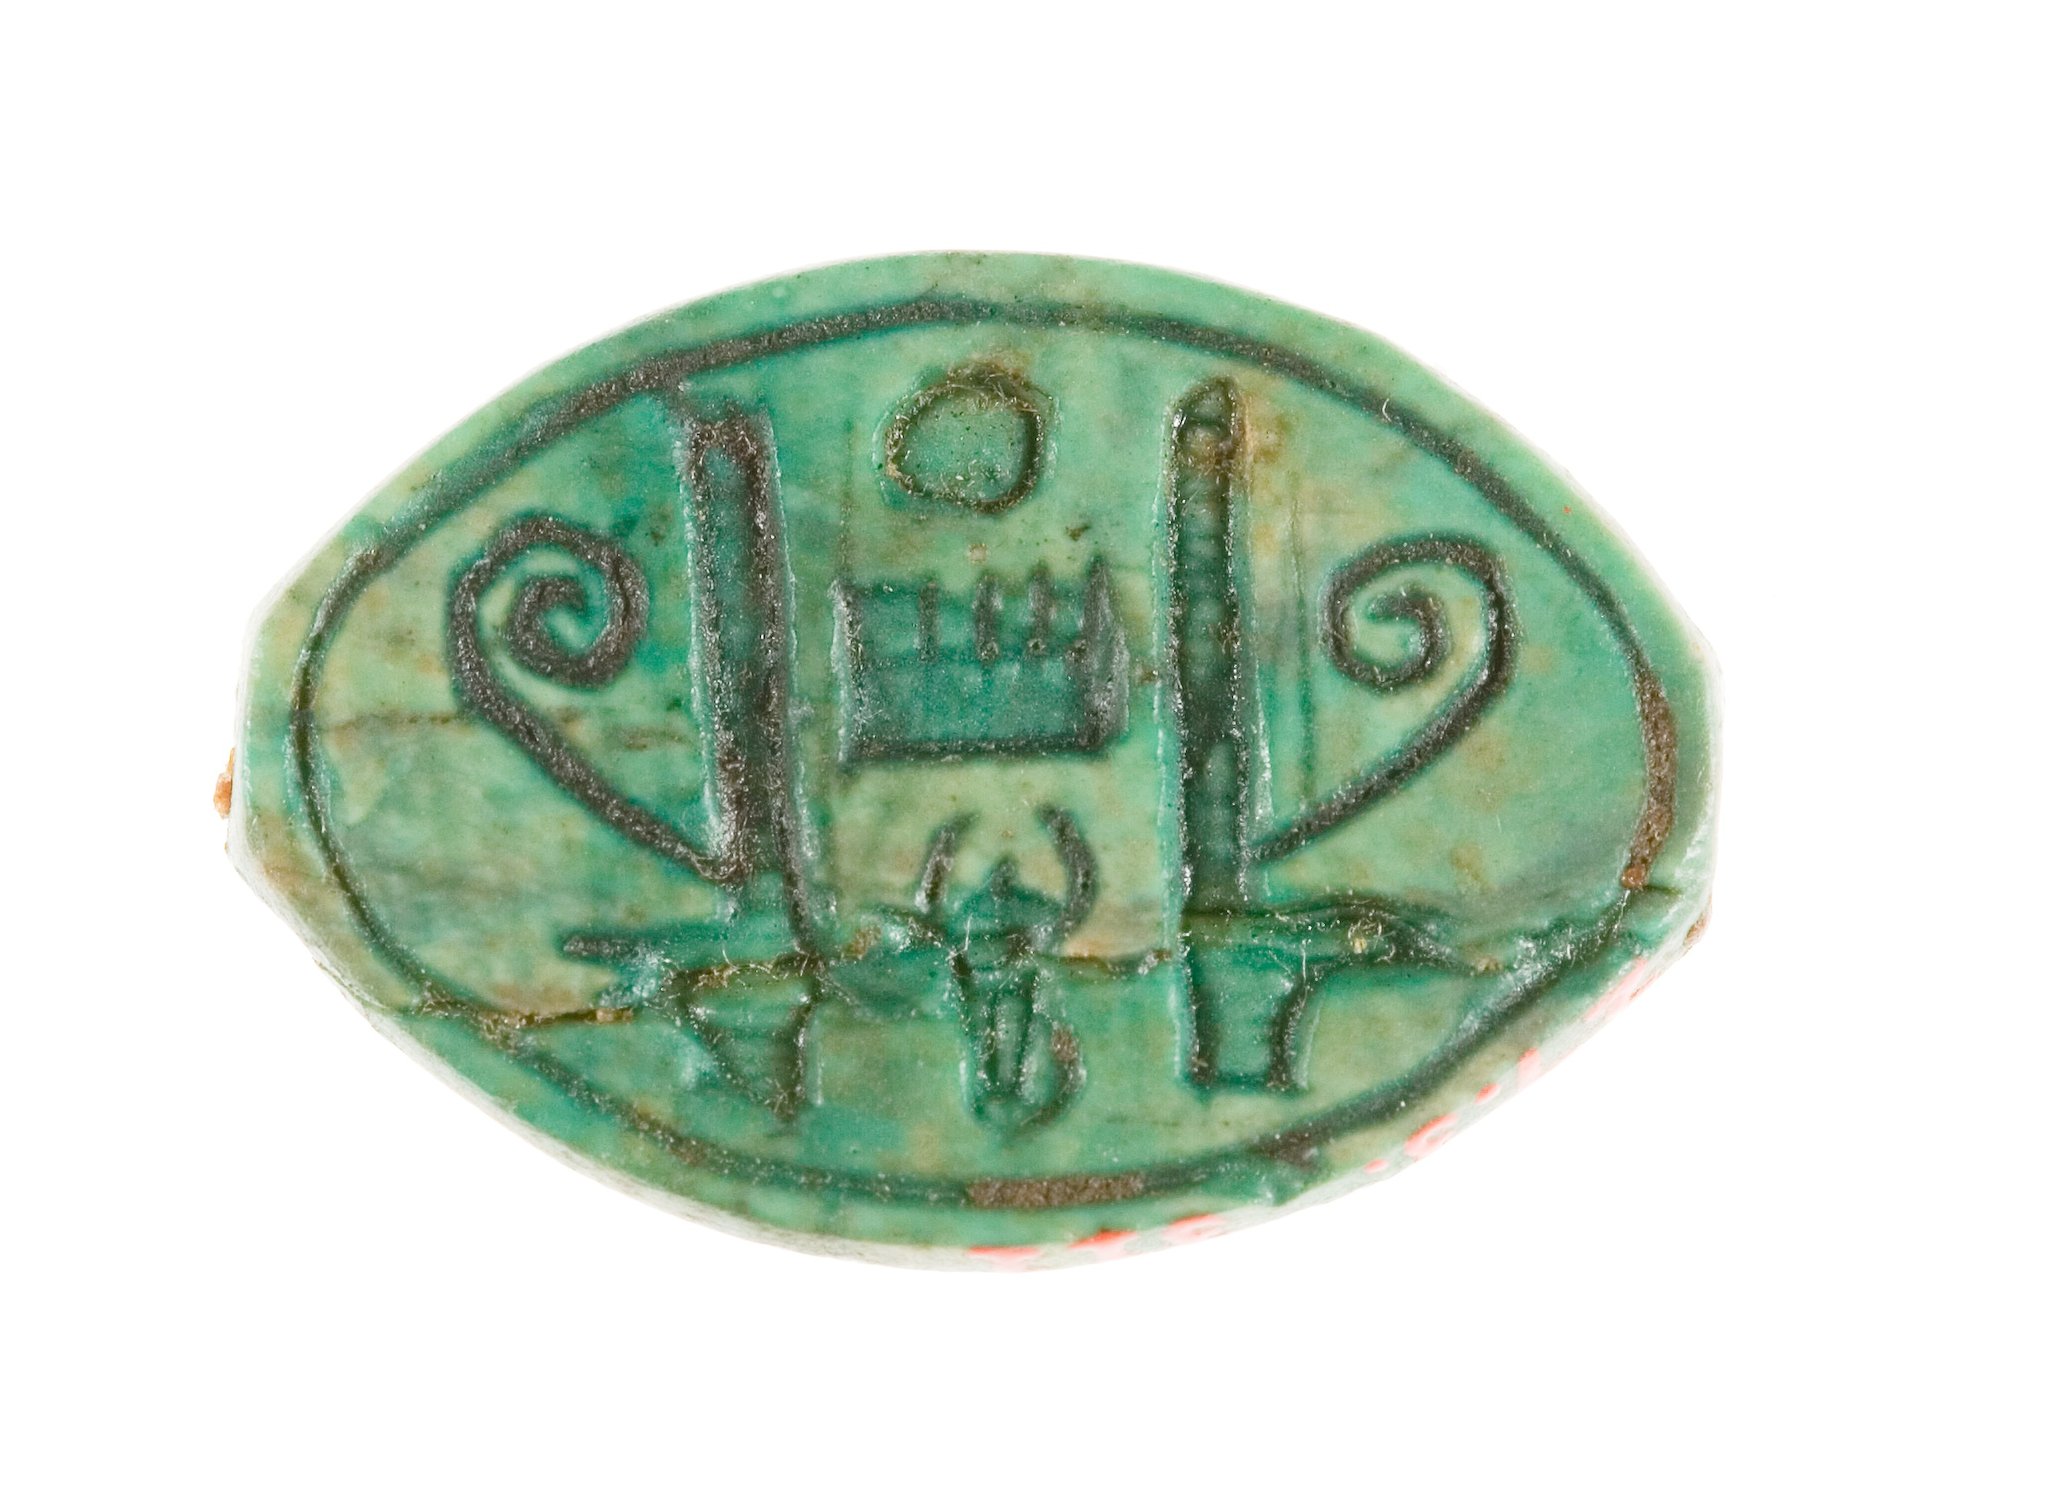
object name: cowroid, hatshepsut fd, menkheperre, red crown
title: Cowroid Seal Amulet Inscribed with the Throne Name of Thutmose III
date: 1479-1458 BCE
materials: stone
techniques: glazing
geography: egypt